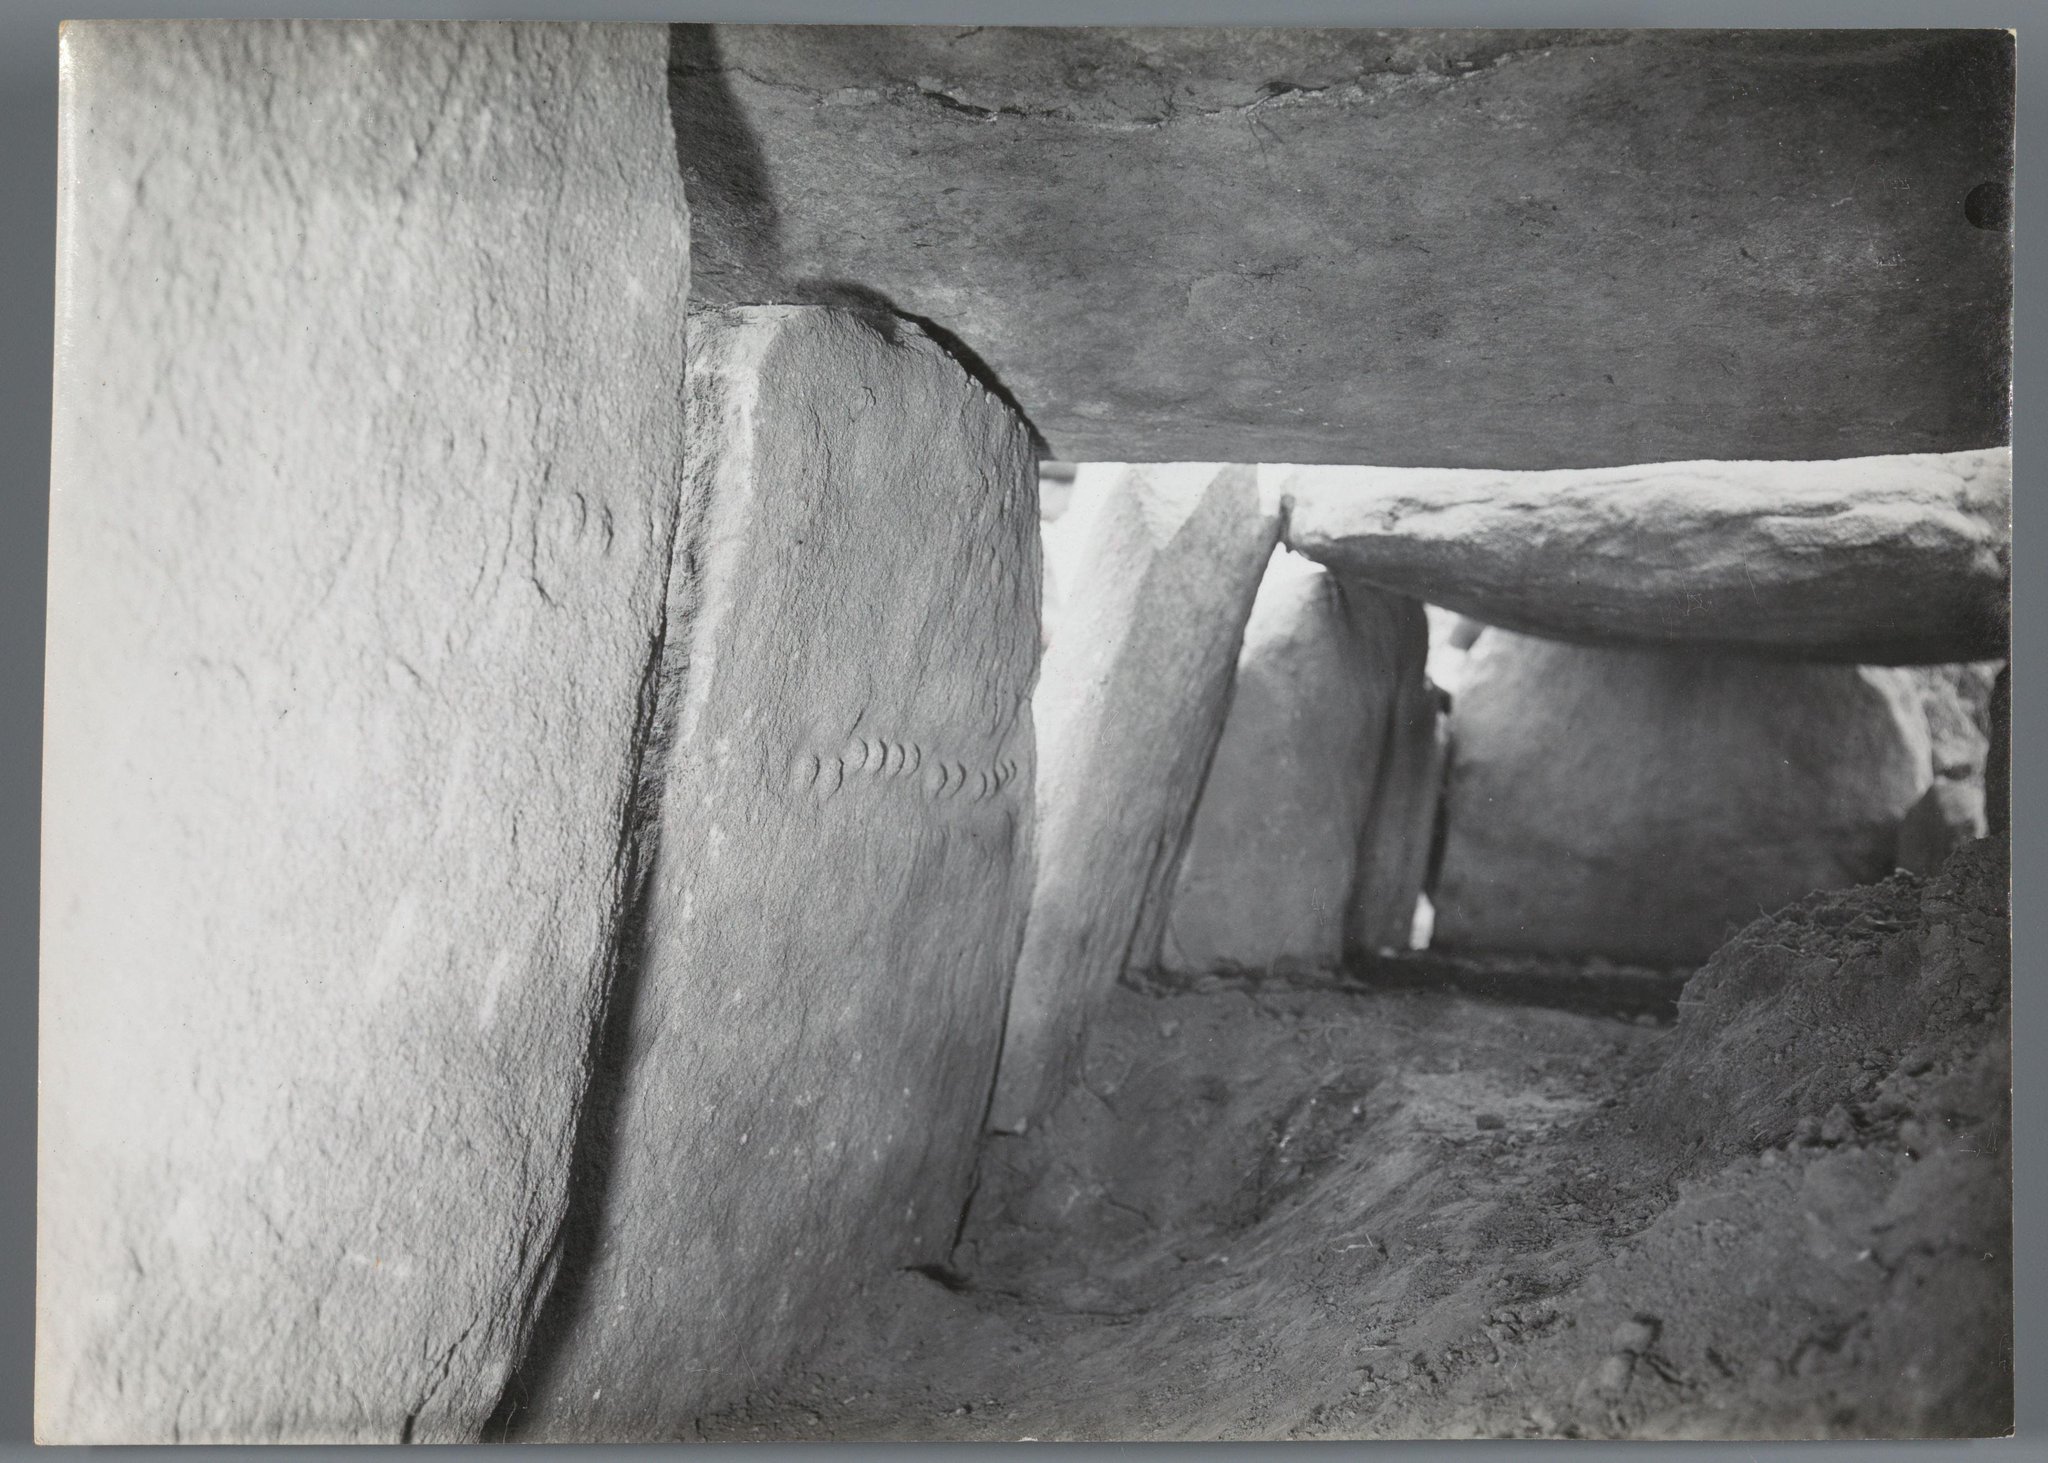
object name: photograph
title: Hunebed van Kerguntuil, Trégastel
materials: paper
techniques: gelatin silver print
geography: trégastel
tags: megalithic chambered tomb, dolmen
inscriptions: inscription: ‘IX/ Ban v Heuvel/ Allée Couverte de Kerguntuil/ Trégastel C. du N./ beeldhouwwerk op twee draagstenen’